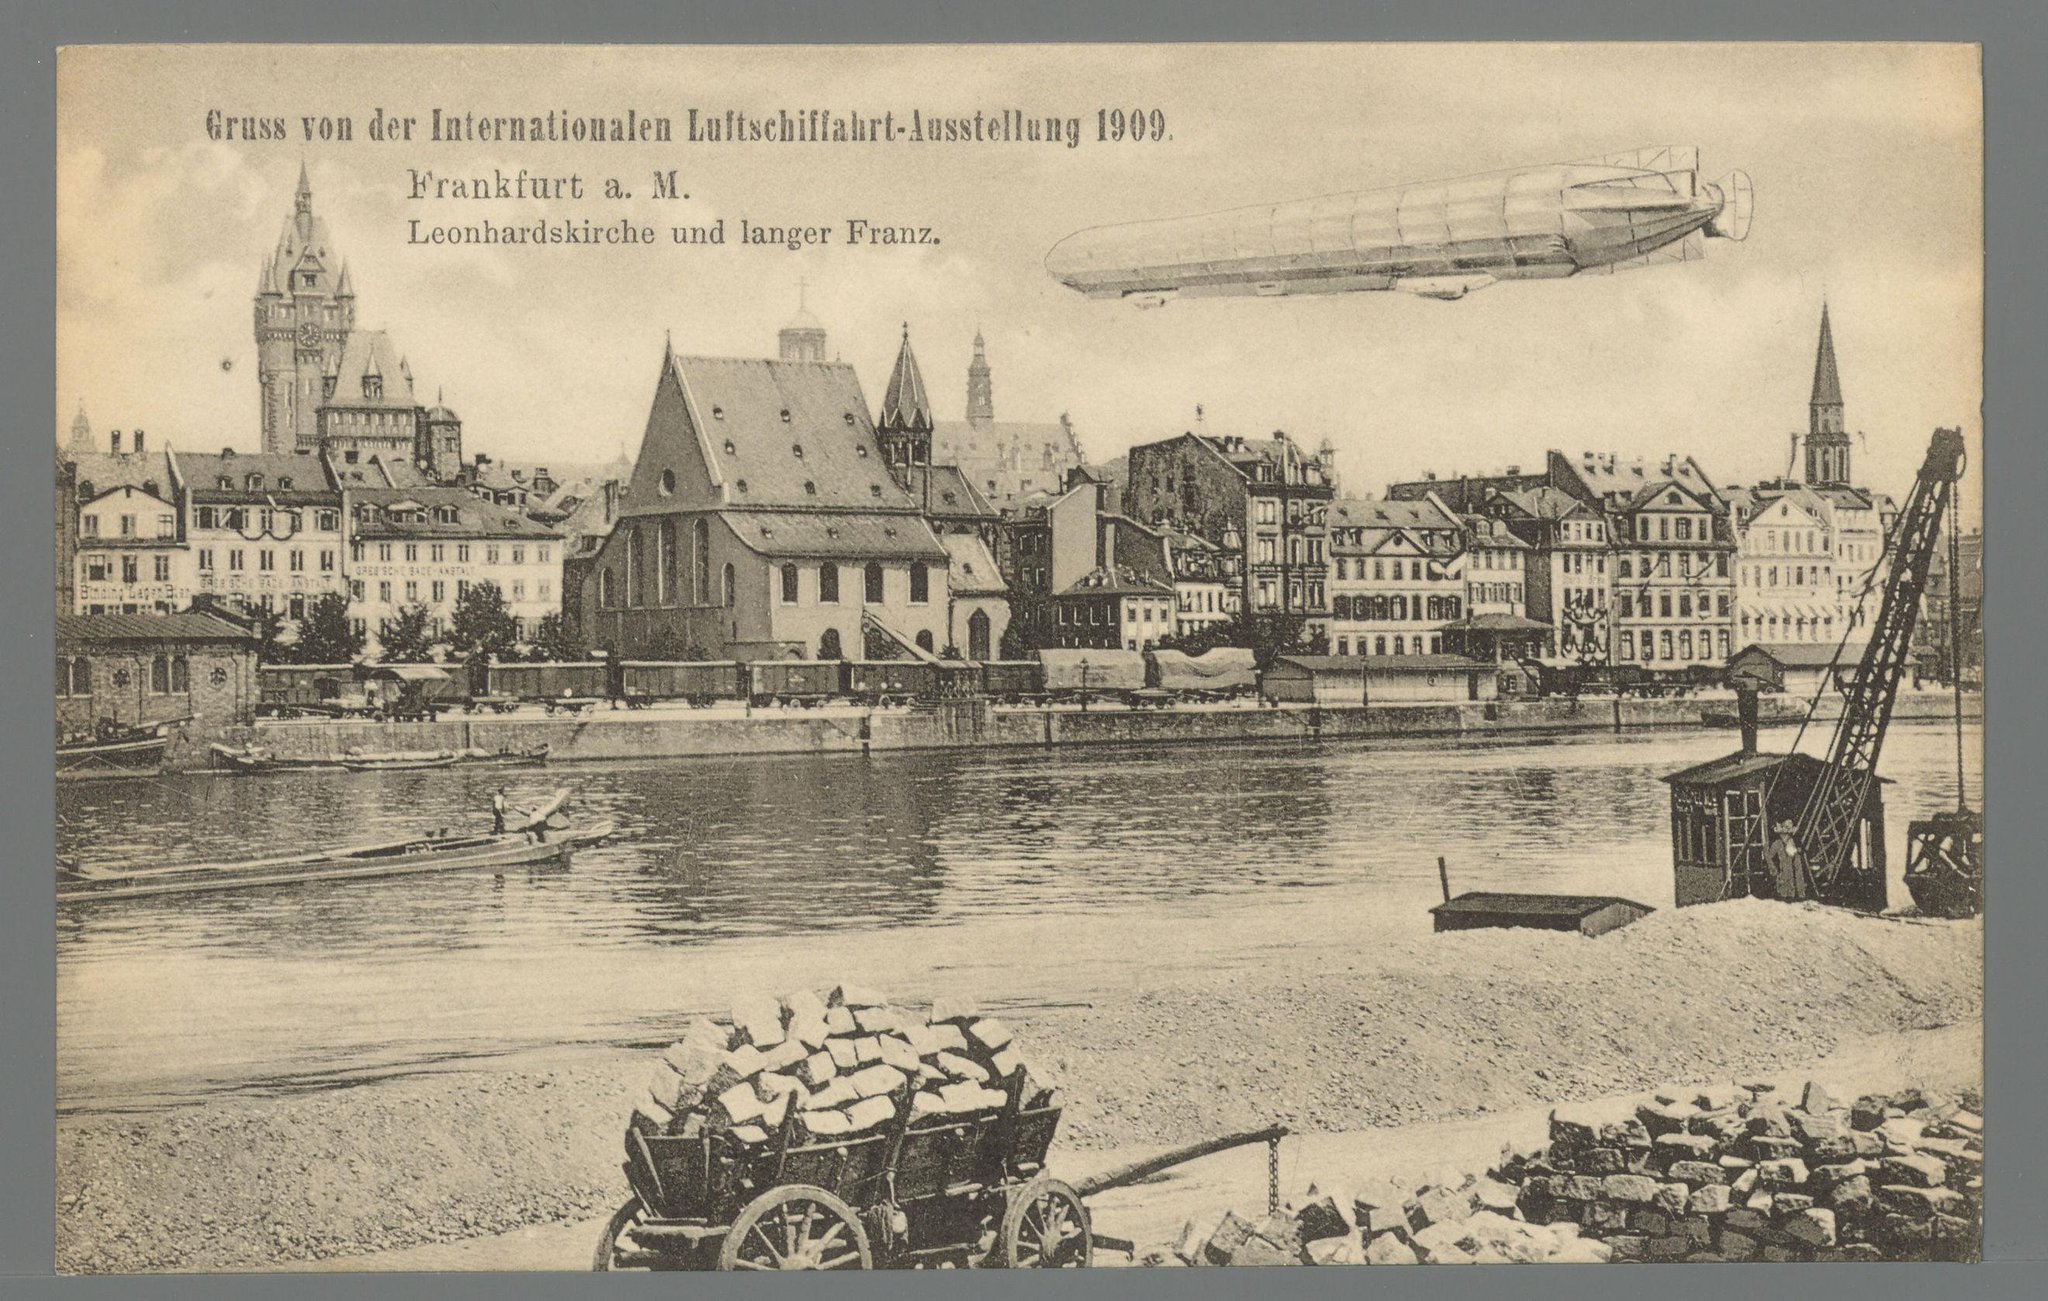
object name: ansichtkaart, prentbriefkaart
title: Gruss von der Internationalen Luftschiffahrt-Ausstellung 1909. Frankfurt a. M. Leonhardskirche und langer Franz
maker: Anonymous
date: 1909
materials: cardboard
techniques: photograph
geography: trier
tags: city-view, and landscape with man-made constructions, church (exterior), canals, waters (in city), temporary exhibition, 'salon'